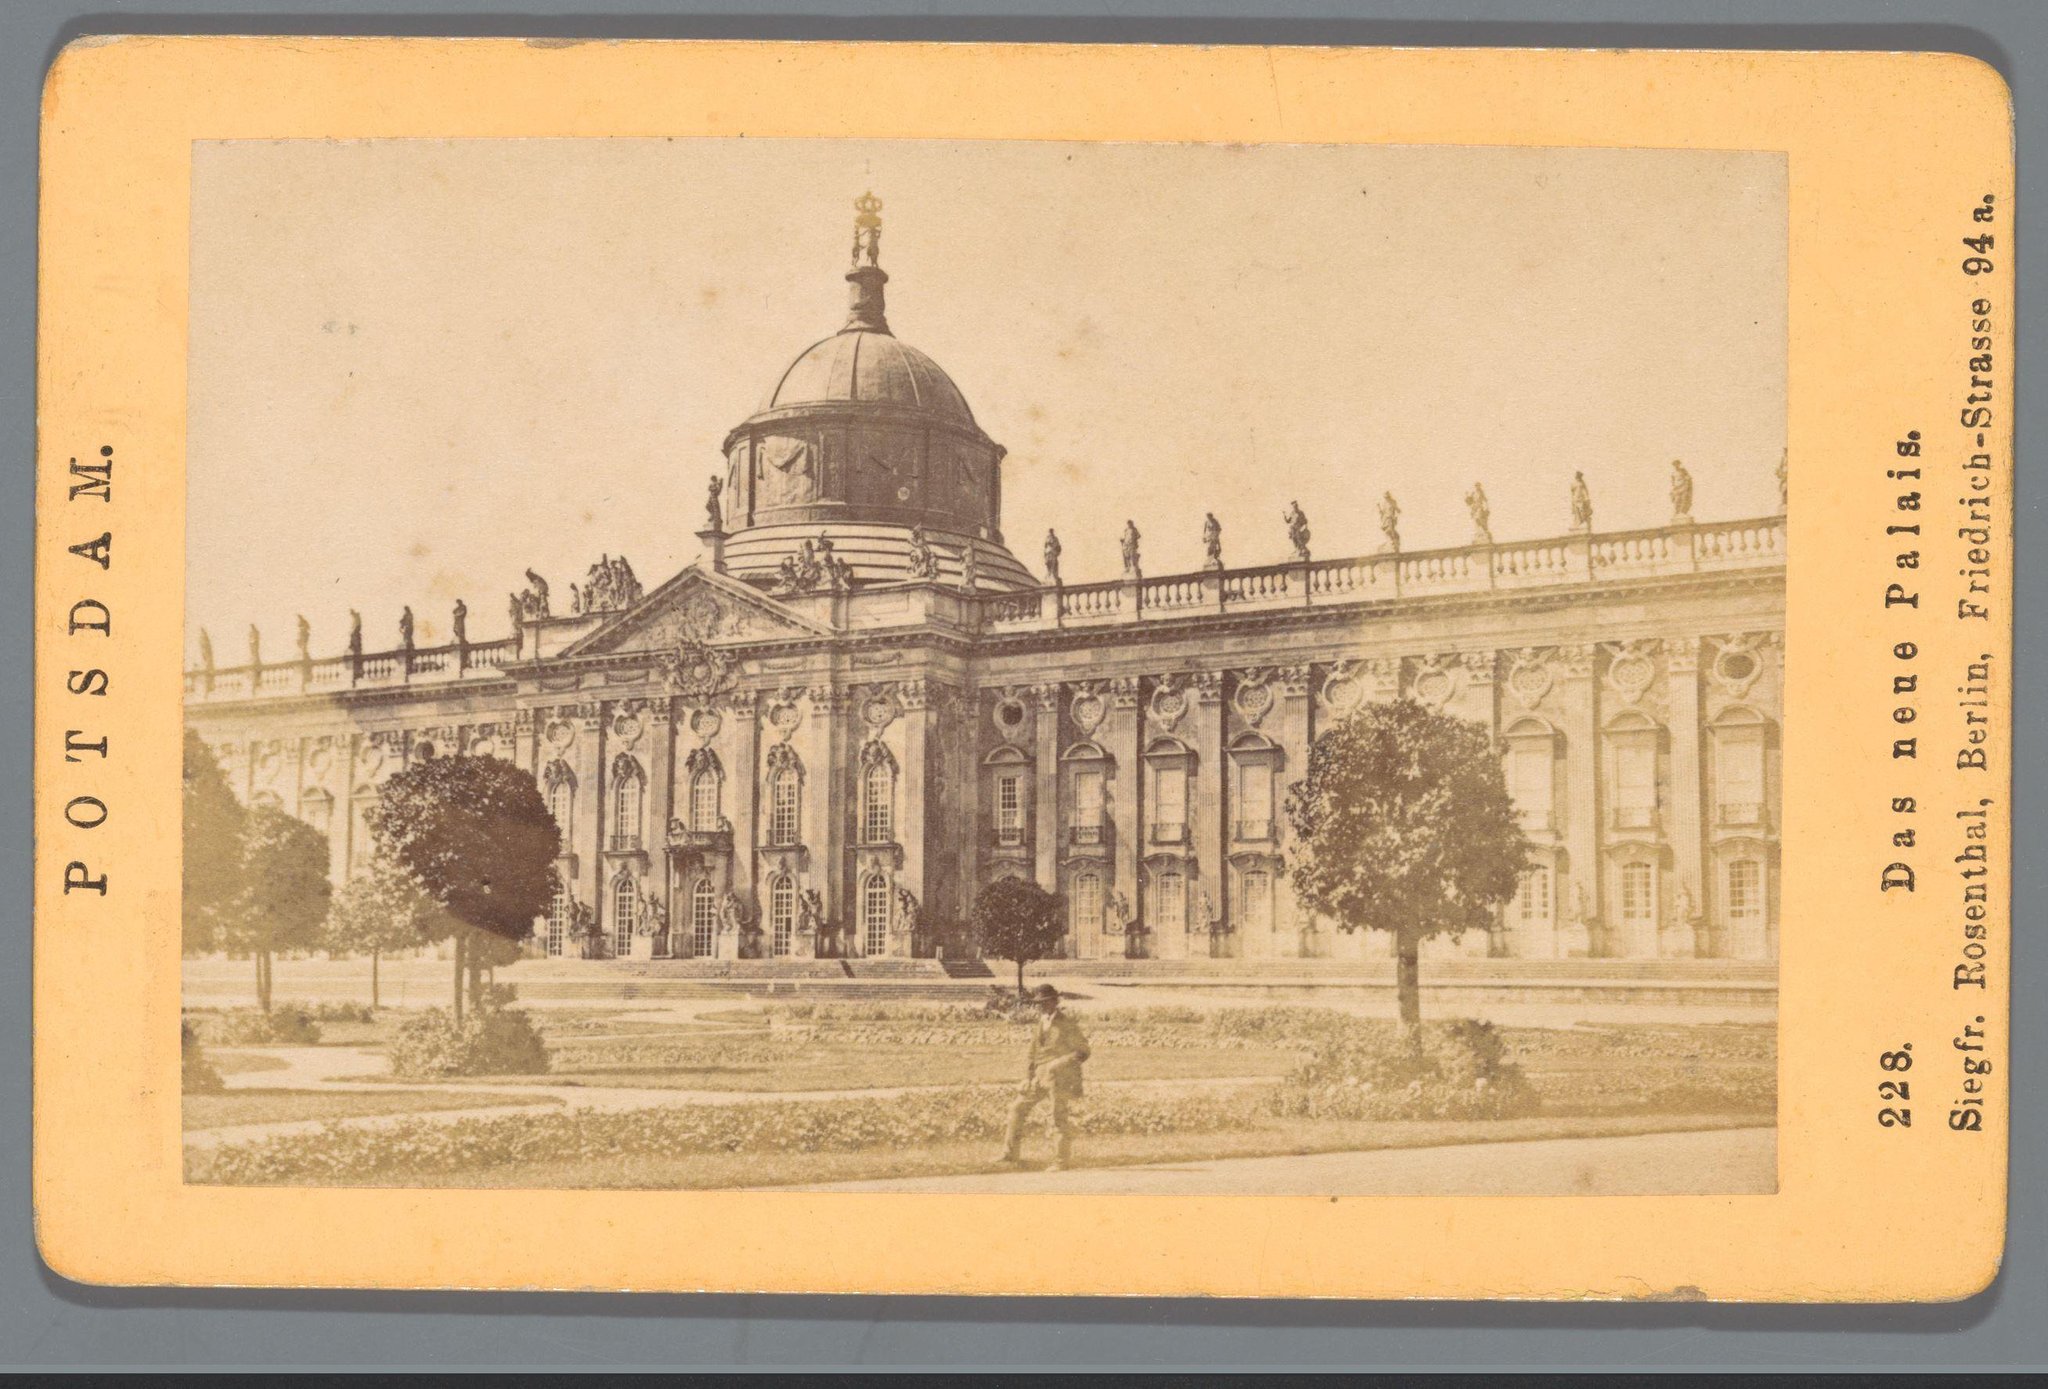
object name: photograph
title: Potsdam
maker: siegfried rosenthal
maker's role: fotograaf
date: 1855-1885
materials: cardboard, paper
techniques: albumen print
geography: potsdam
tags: palace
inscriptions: number: ‘228.’, address: ‘Berlin, Friedrich-Strasse 94a.’